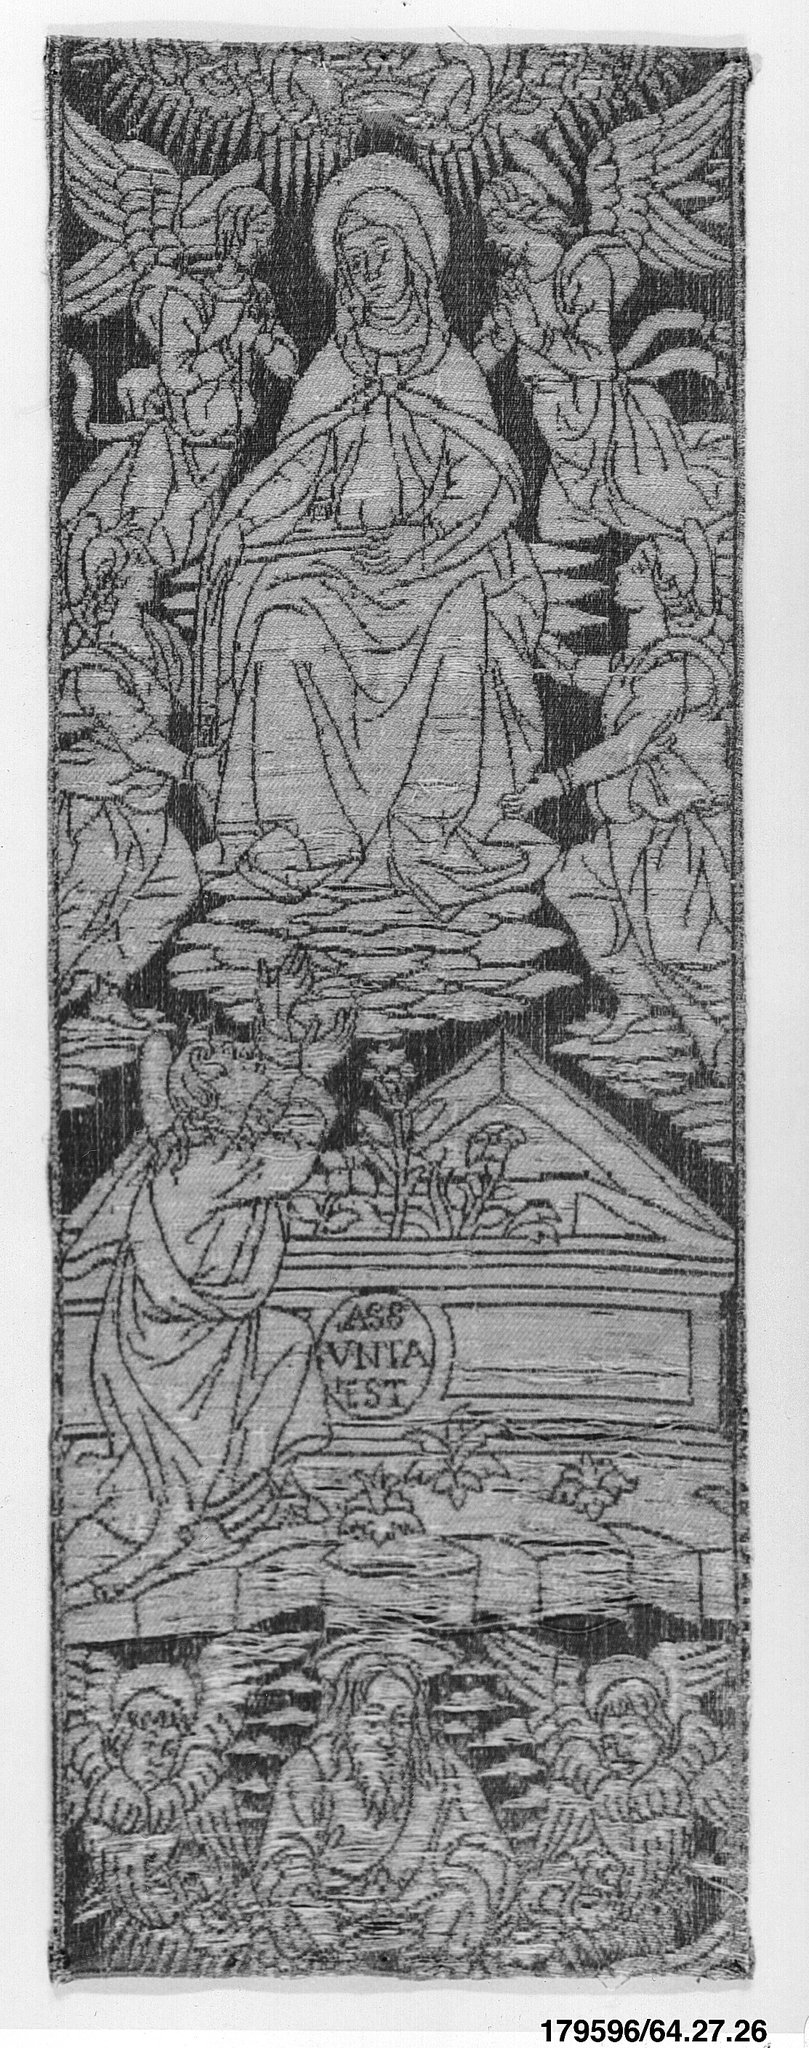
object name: orphrey fragment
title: Part of an orphrey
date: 1467-1533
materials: linen, metal thread, silk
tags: angels,assumption of the virgin